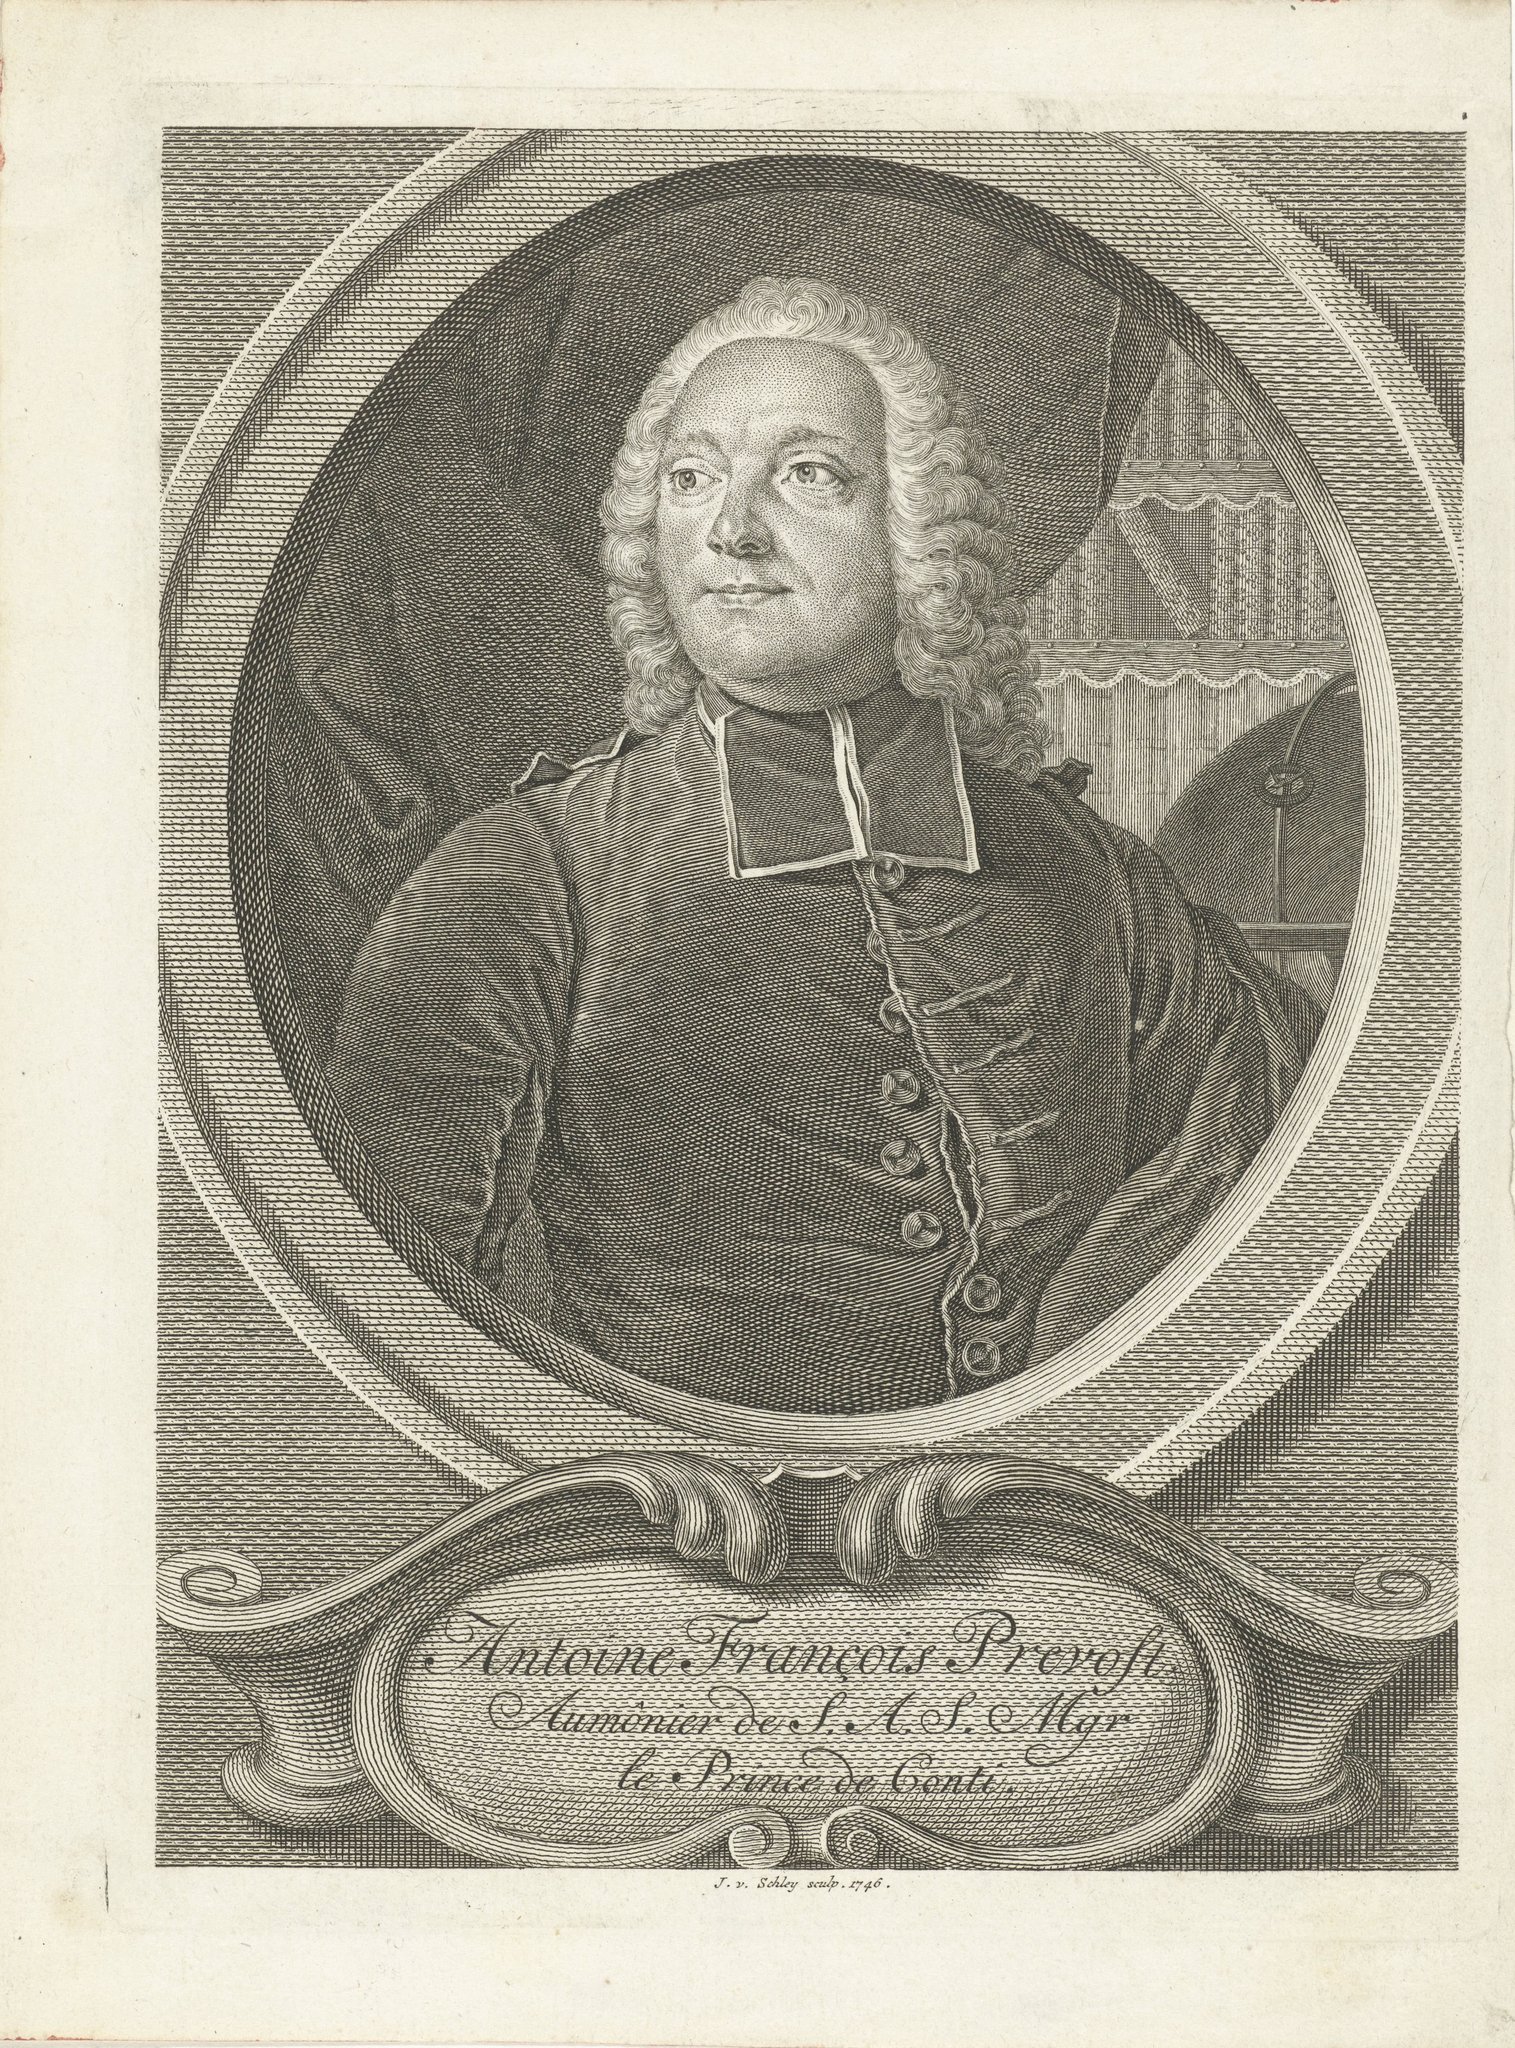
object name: print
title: Portret van Antoine François Prevost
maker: jacob van der schley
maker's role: draughtsman, print maker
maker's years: 1715-1779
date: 1746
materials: paper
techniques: engraving, etching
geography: amsterdam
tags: study; 'studiolo'; library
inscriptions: date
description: Portret van de Franse auteur Antoine François Prevost, tevens bekend als Abbé Prévost. Hij is gekleed in toga met bef. Op de achtergrond een boekenkast. In de cartouche zijn naam en titels.